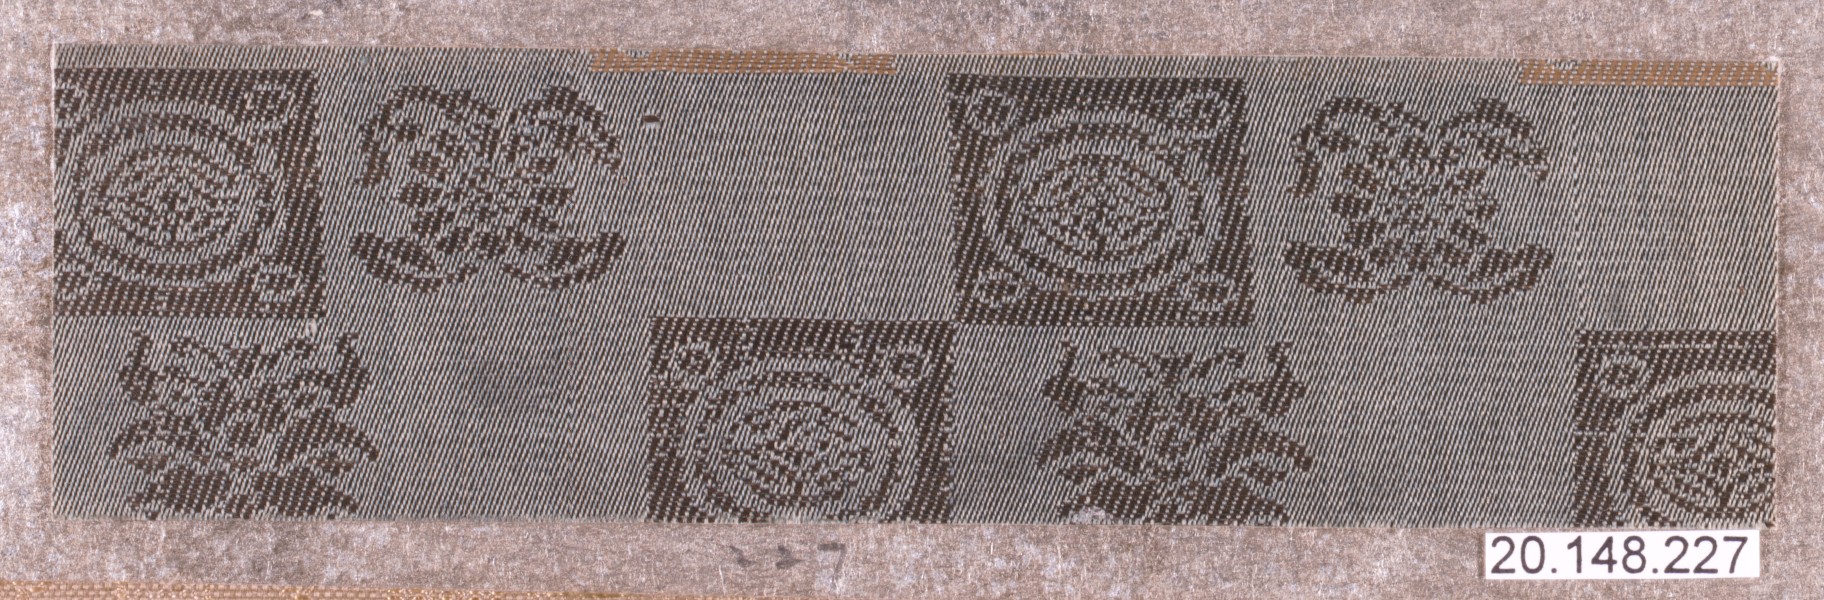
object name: piece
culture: japanese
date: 1701-1800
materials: silk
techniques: compound weave